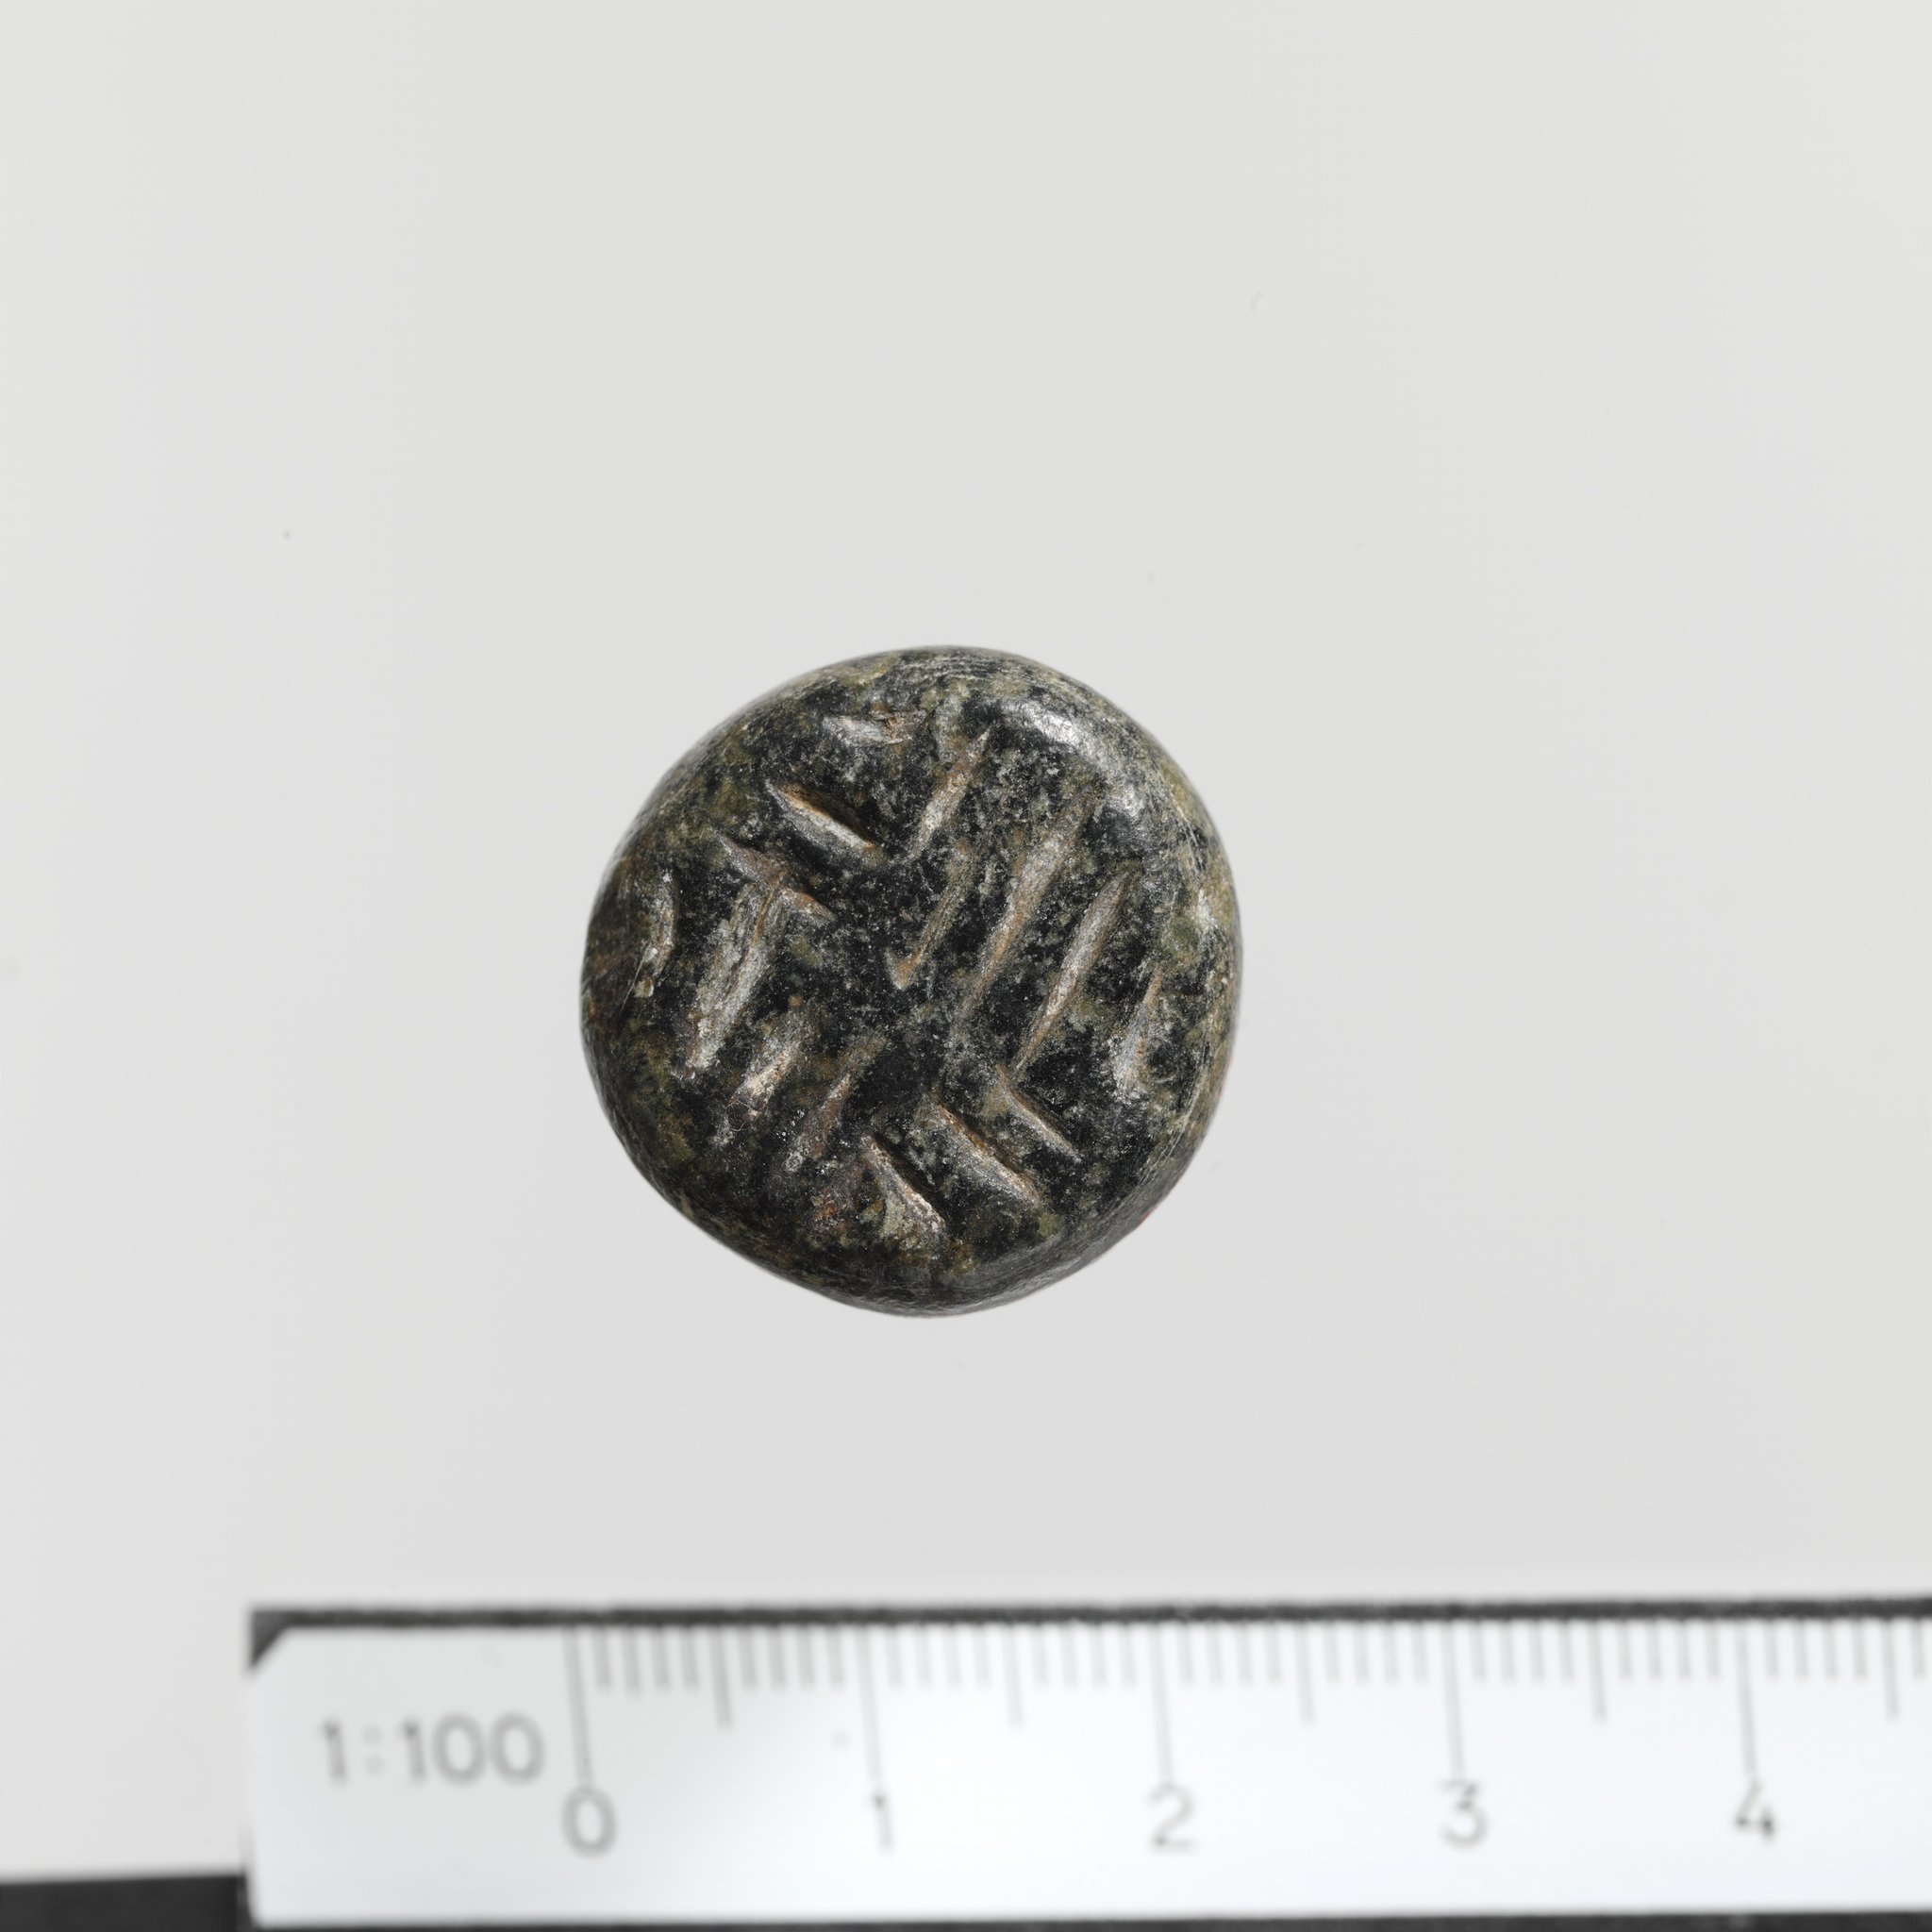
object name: seal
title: Serpentine conoid seal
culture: minoan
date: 2400-2200 BCE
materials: stone